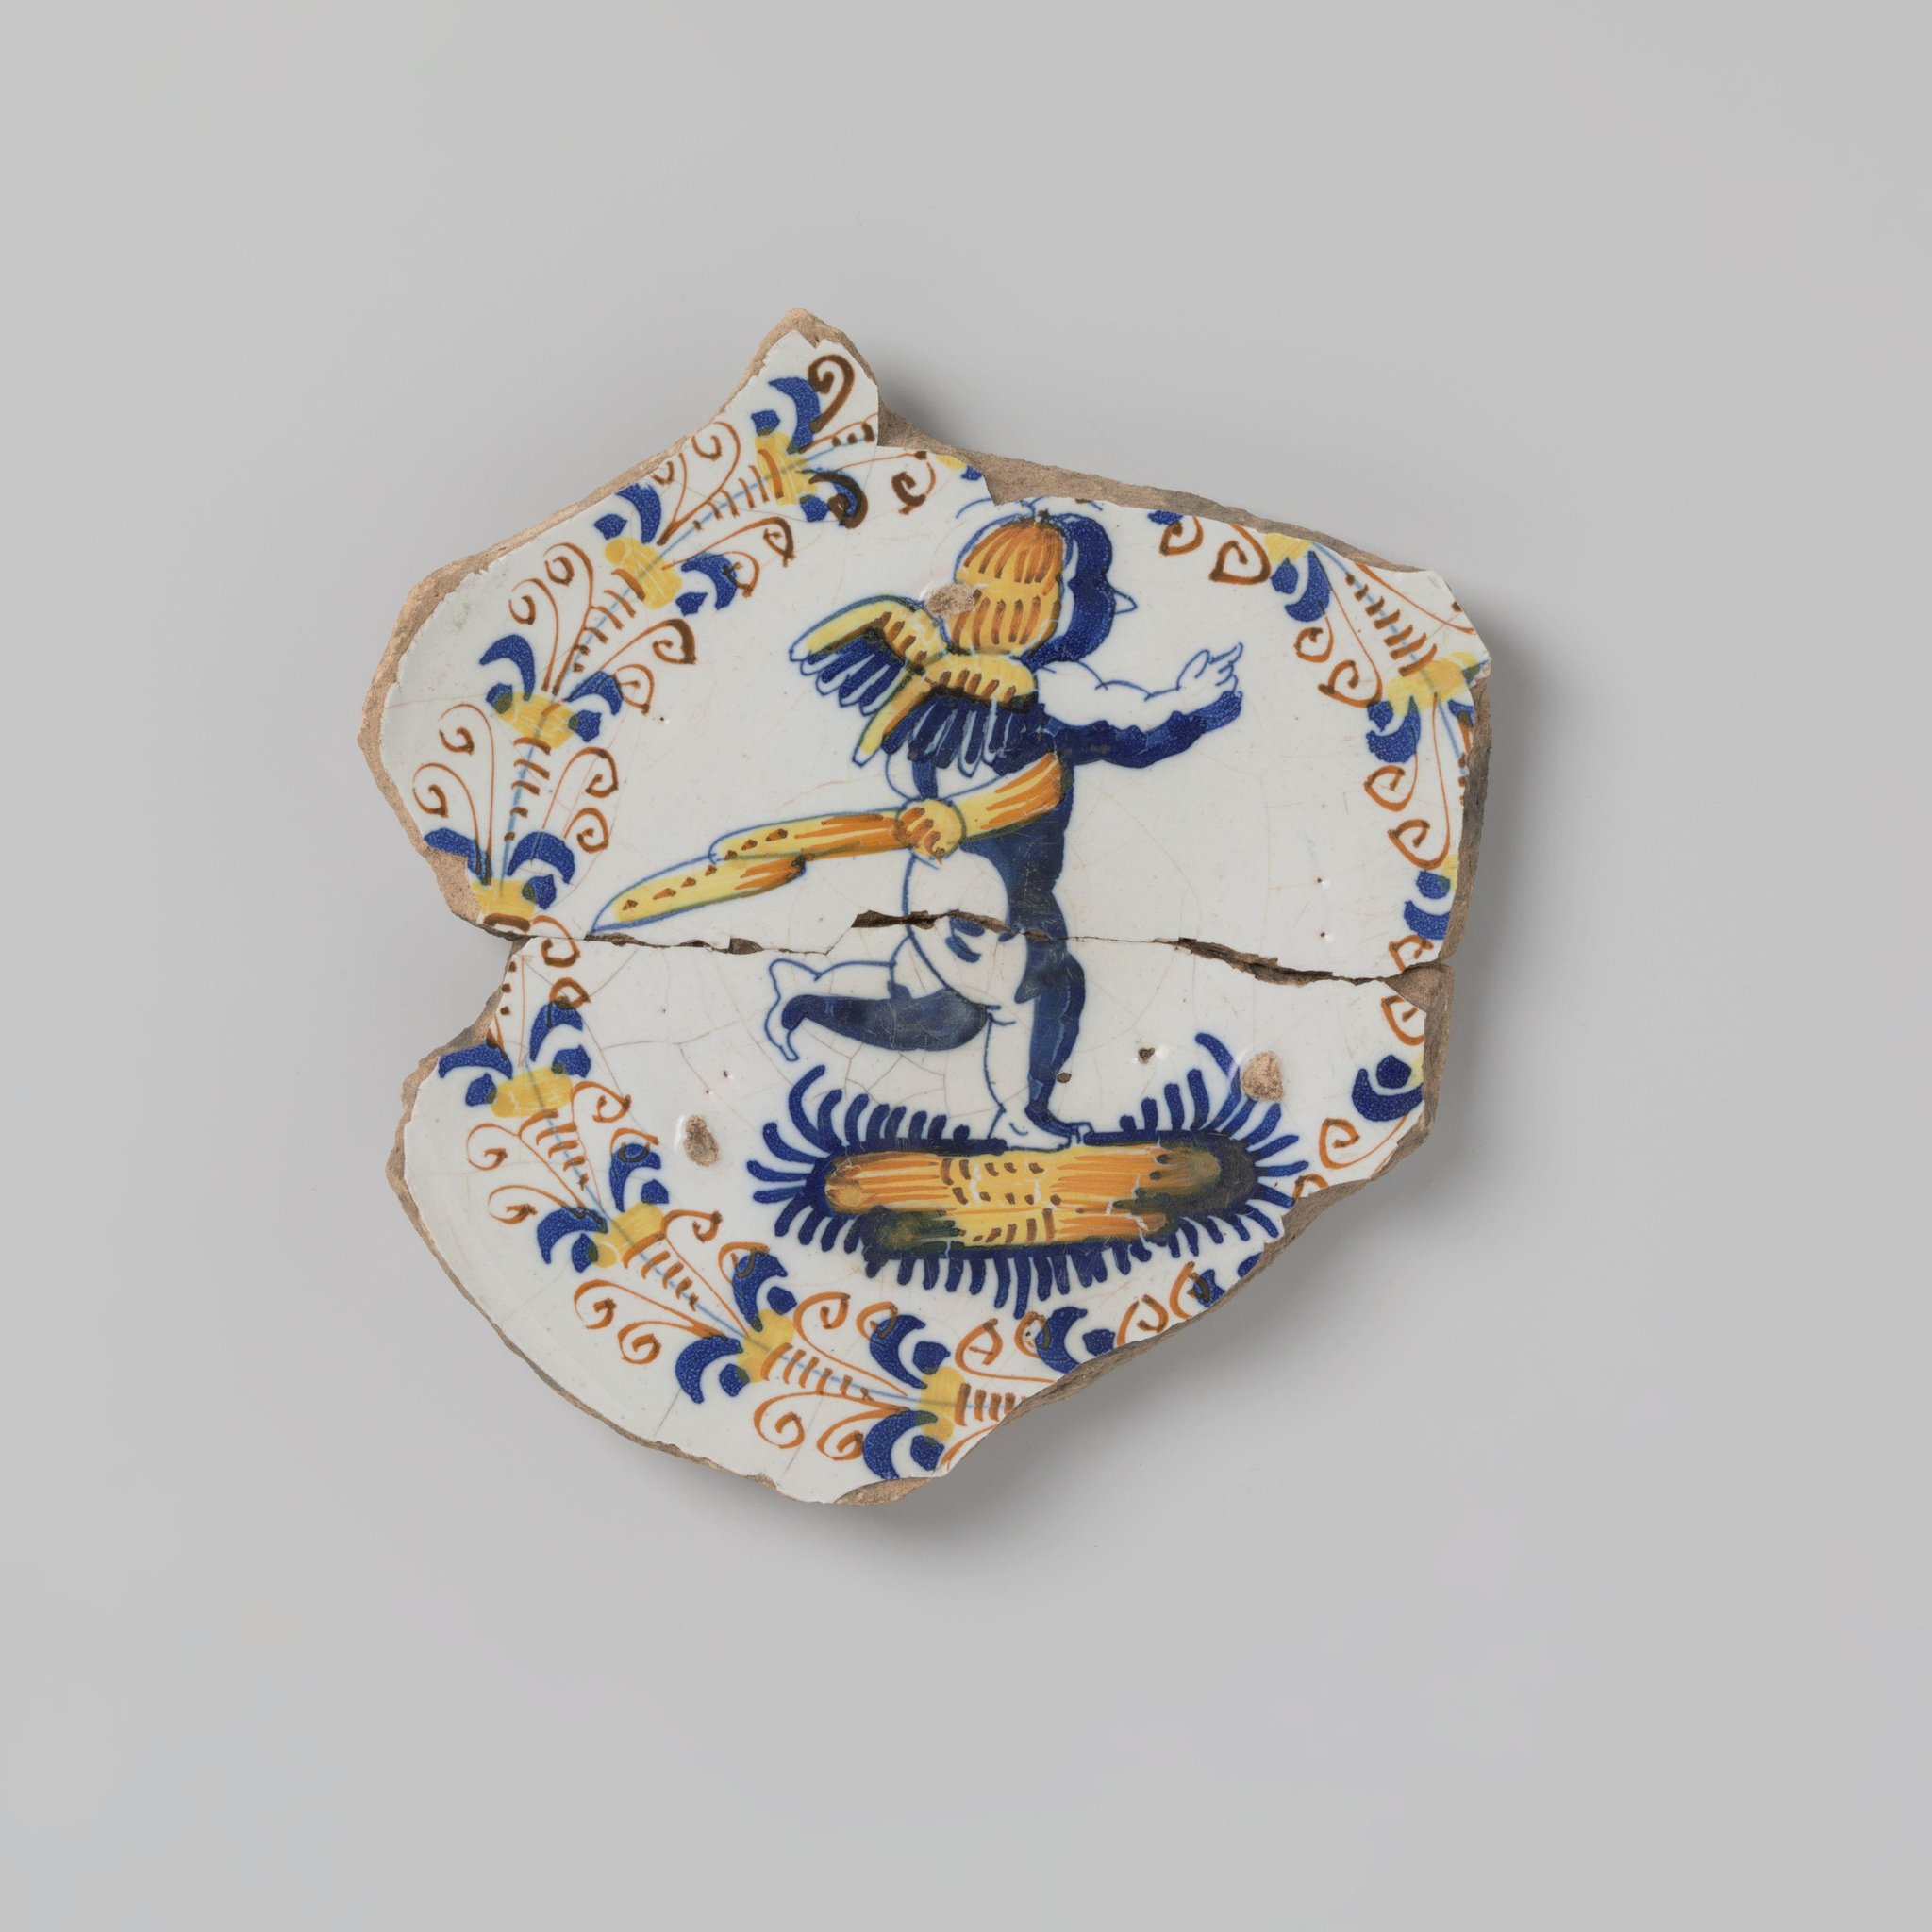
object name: sherd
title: Schotelscherf van aardewerk met veelkleurige tekening van een putto in een sierrand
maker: Anonymous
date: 1500-1799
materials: earthenware, glaze